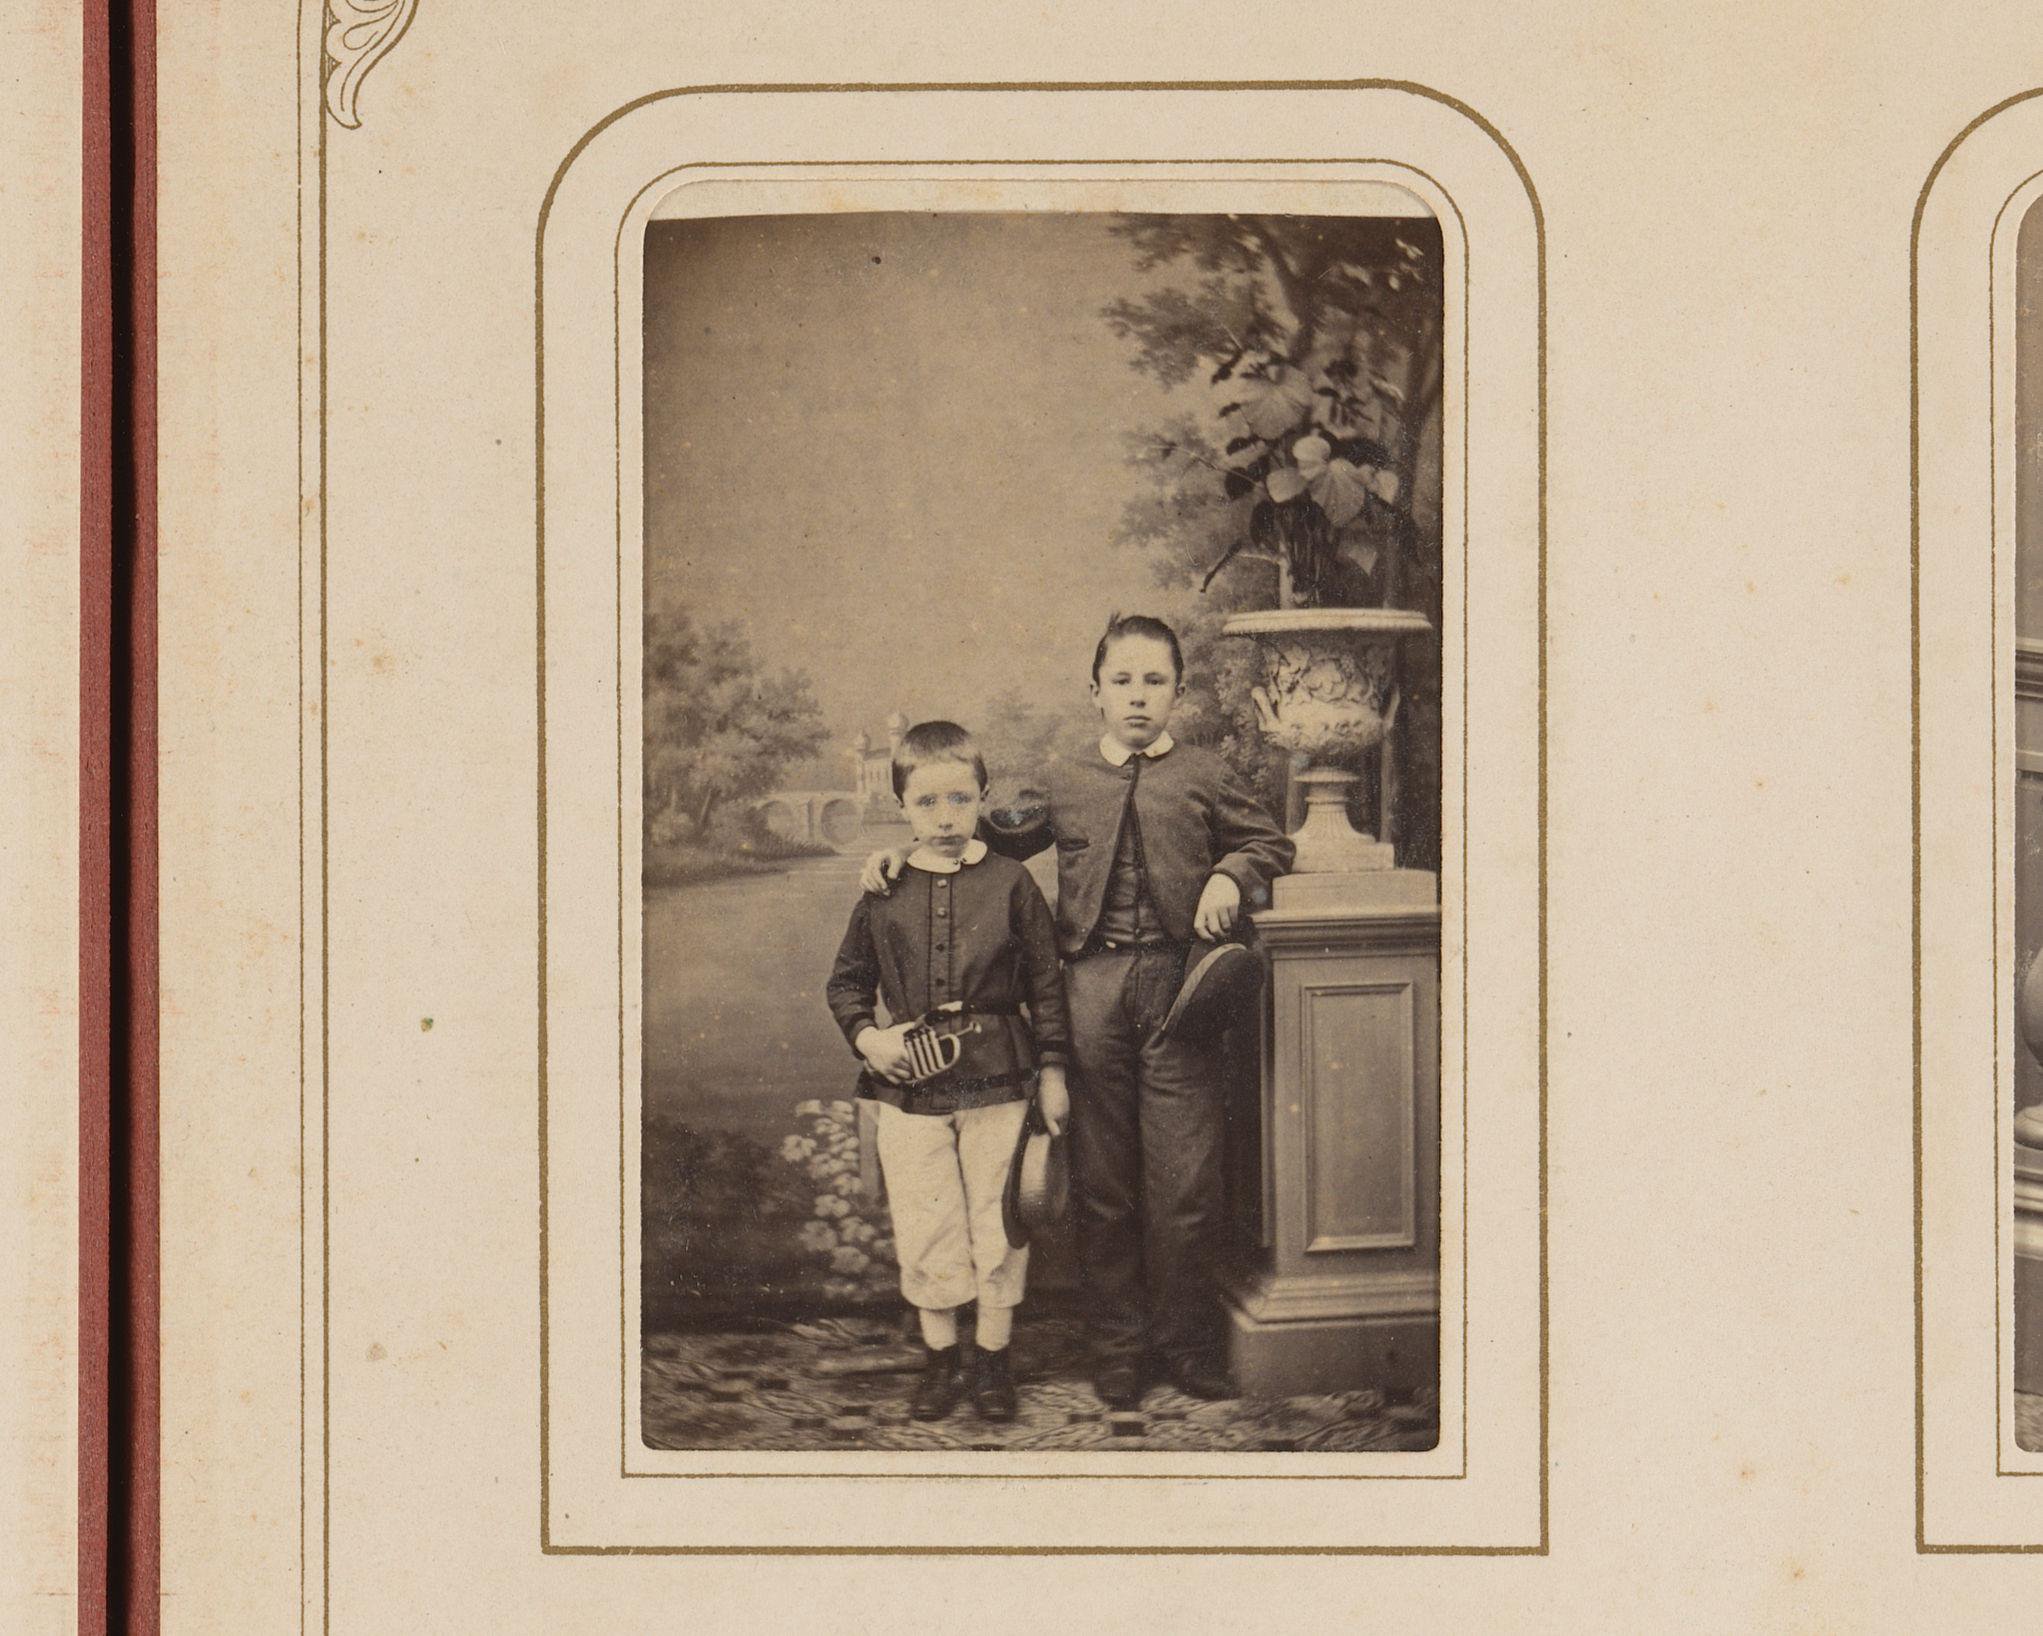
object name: carte de visite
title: Portret van twee jongens bij een zuil, met trompet en hoed in de hand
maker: k. moen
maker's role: fotograaf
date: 1850-1900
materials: cardboard, photographic support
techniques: albumen print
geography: zeist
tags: boy (child between toddler and youth) (+ two persons), historical persons, pedestal of a piece of sculpture (perhaps in the form of a herm)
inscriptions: inscription: ‘K. Moen./ Photograaf./ ZEIJST’